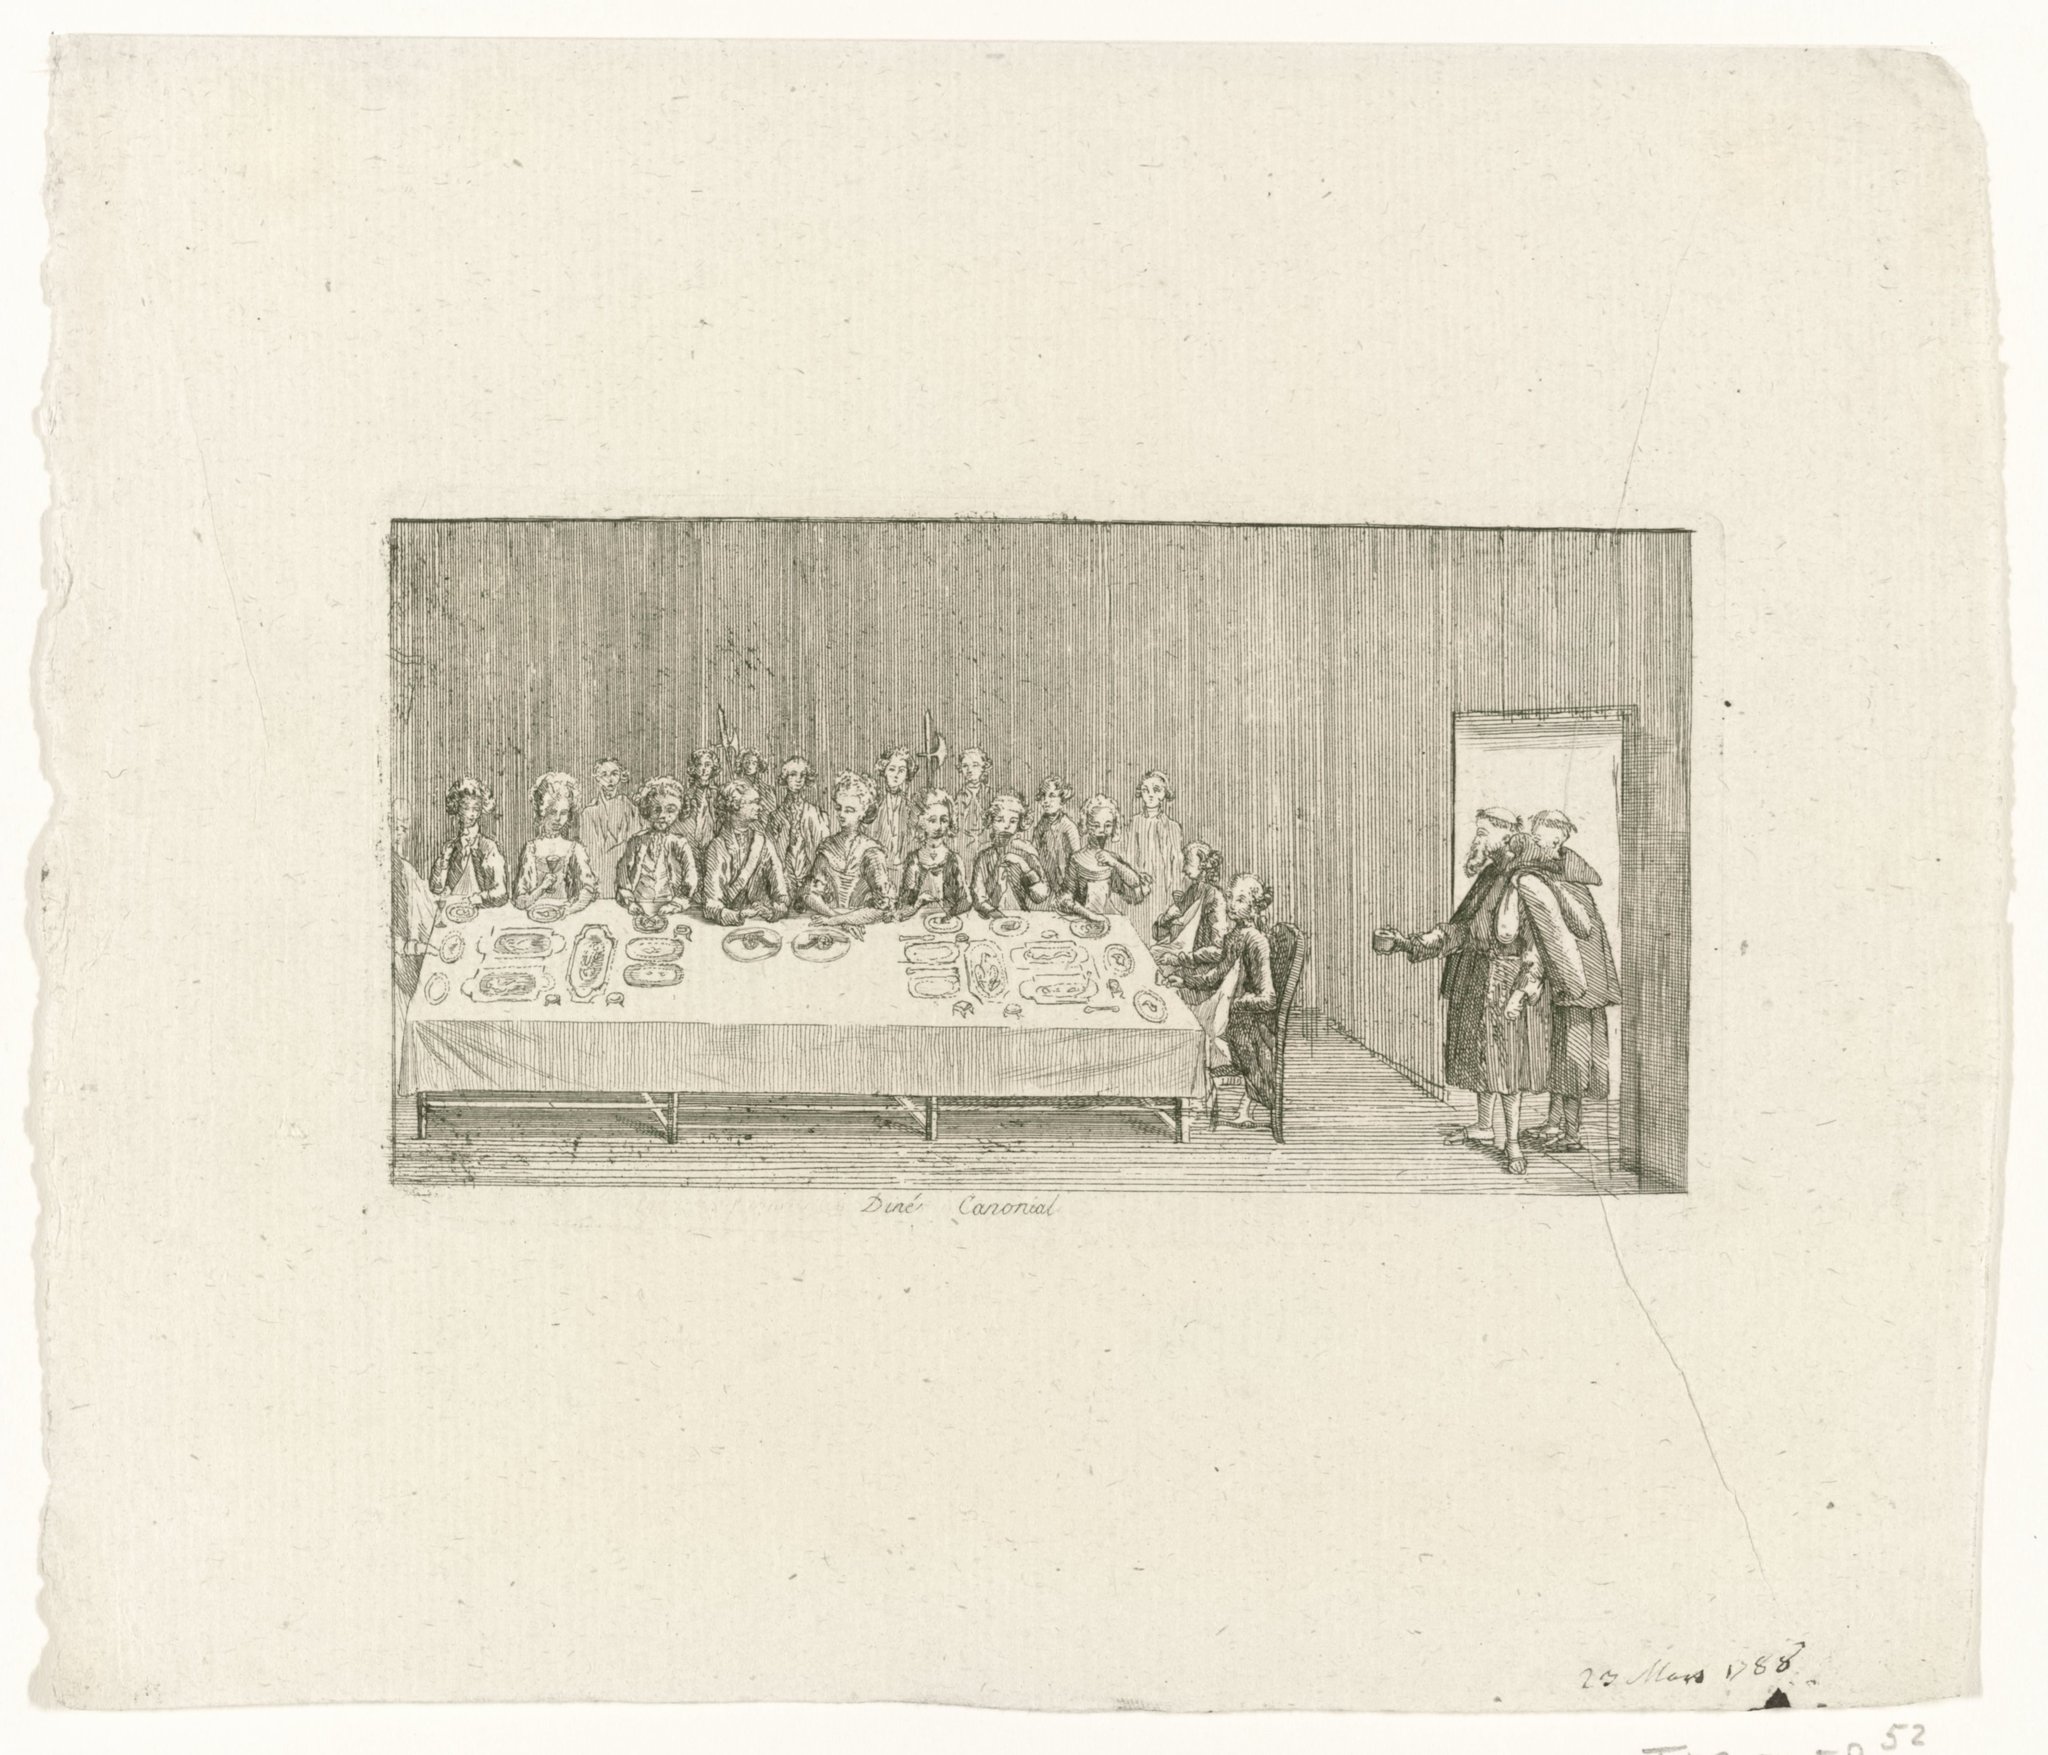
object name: print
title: Diné Canonial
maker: Anonymous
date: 1787-1790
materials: paper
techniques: engraving, etching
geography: southern netherlands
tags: monk(s), friar(s), celebration meal, feast, banquet, beggar, brabant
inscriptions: collector's mark: Lugt 2228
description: Spotprent met een groep elegante mannen en vrouwen gezeten aan een feestmaal, in de deuropening staan twee bedelmonikken met een bedelnap. Met de datum 23 maart 1788 in handschrift. Onderdeel van een grote groep van prenten betrekking hebbend op de gebeurtenissen van de Brabantse Omwenteling en de periode 1787-1790.